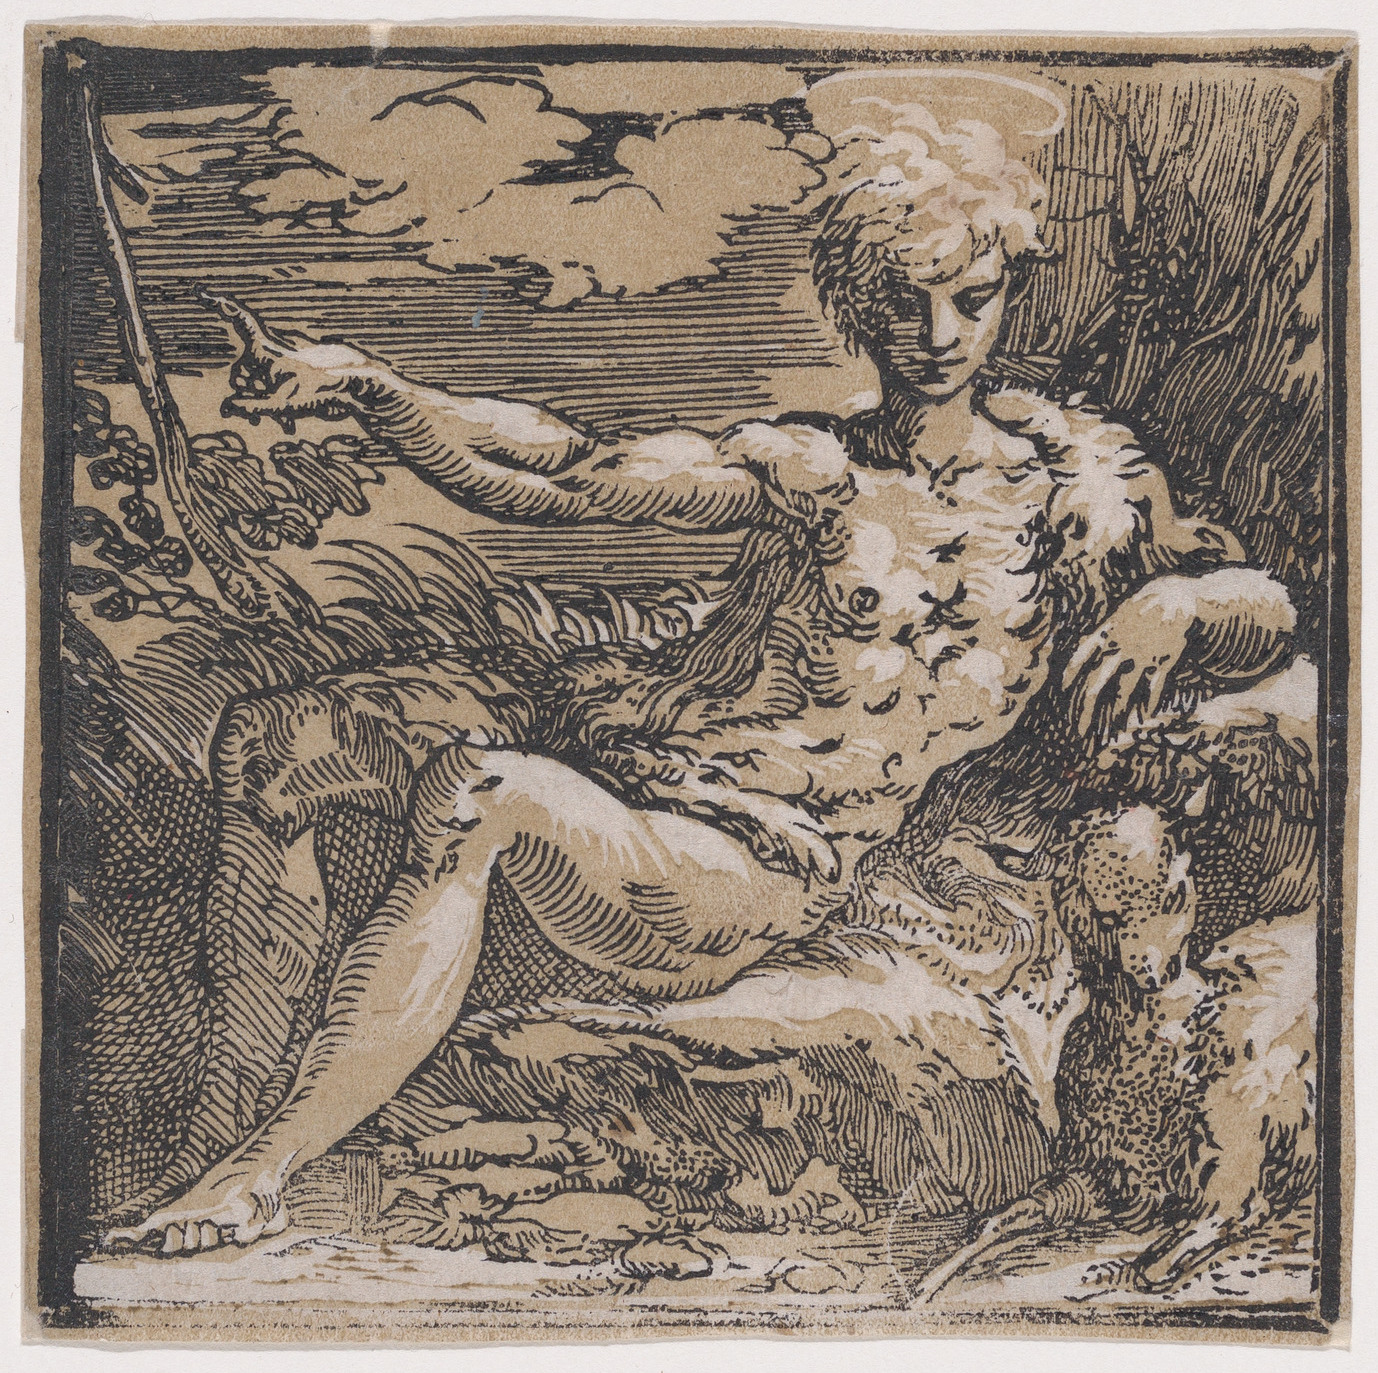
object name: print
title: Young Saint John the Baptist in the desert, a lamb at his side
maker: antonio da trento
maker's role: artist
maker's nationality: italian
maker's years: 1510-1550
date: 1527-1530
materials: ink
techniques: woodcut, printing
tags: saint john the baptist